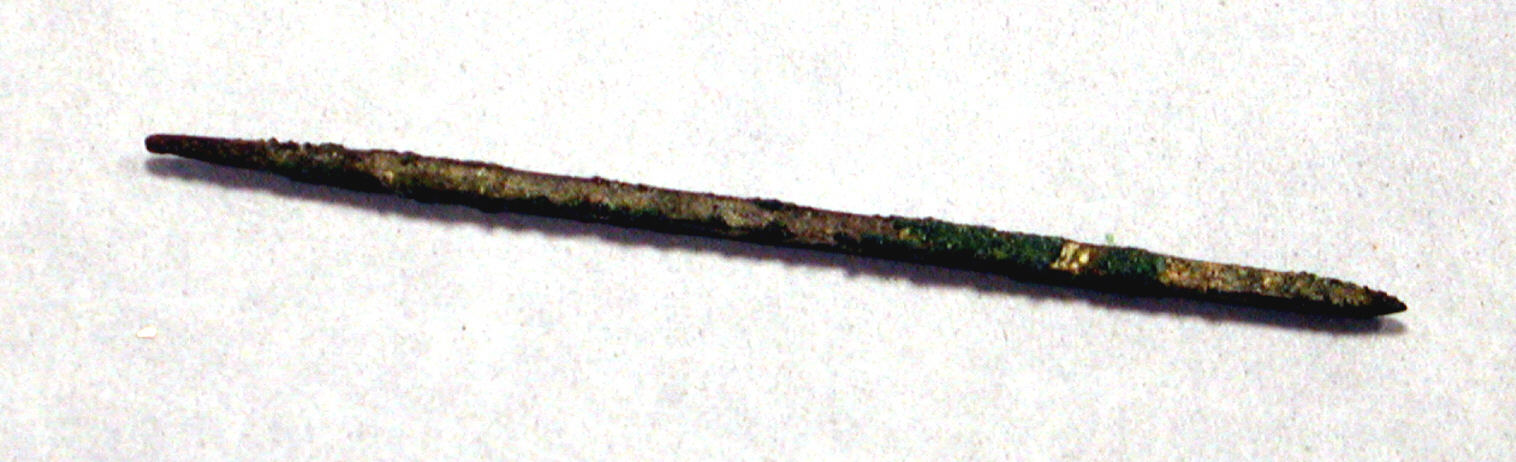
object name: point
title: Barbed Point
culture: vicús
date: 300 BCE-200 CE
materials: copper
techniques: casting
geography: peru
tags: weapons